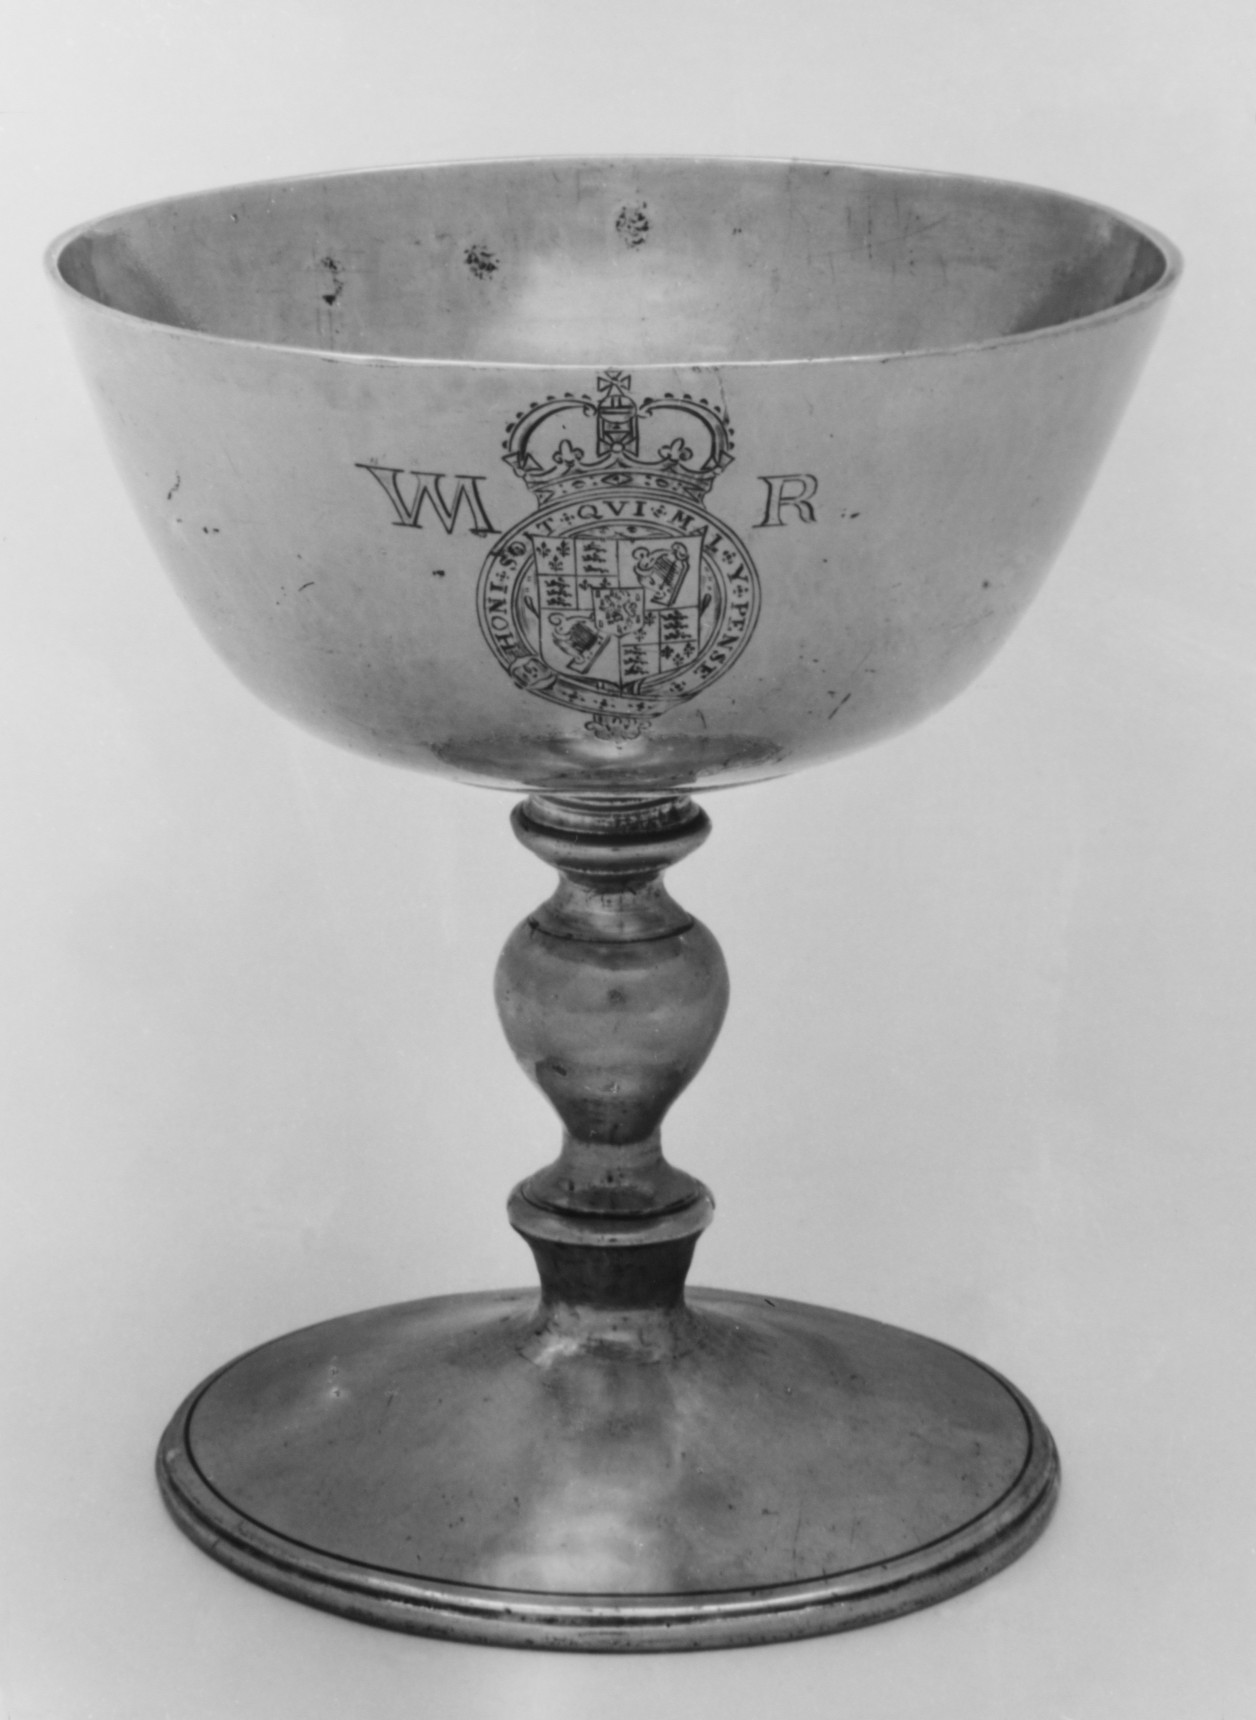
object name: communion cup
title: Communion cup (one of a pair)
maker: w. h., london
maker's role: maker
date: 1660-1661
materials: silver gilt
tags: coat of arms